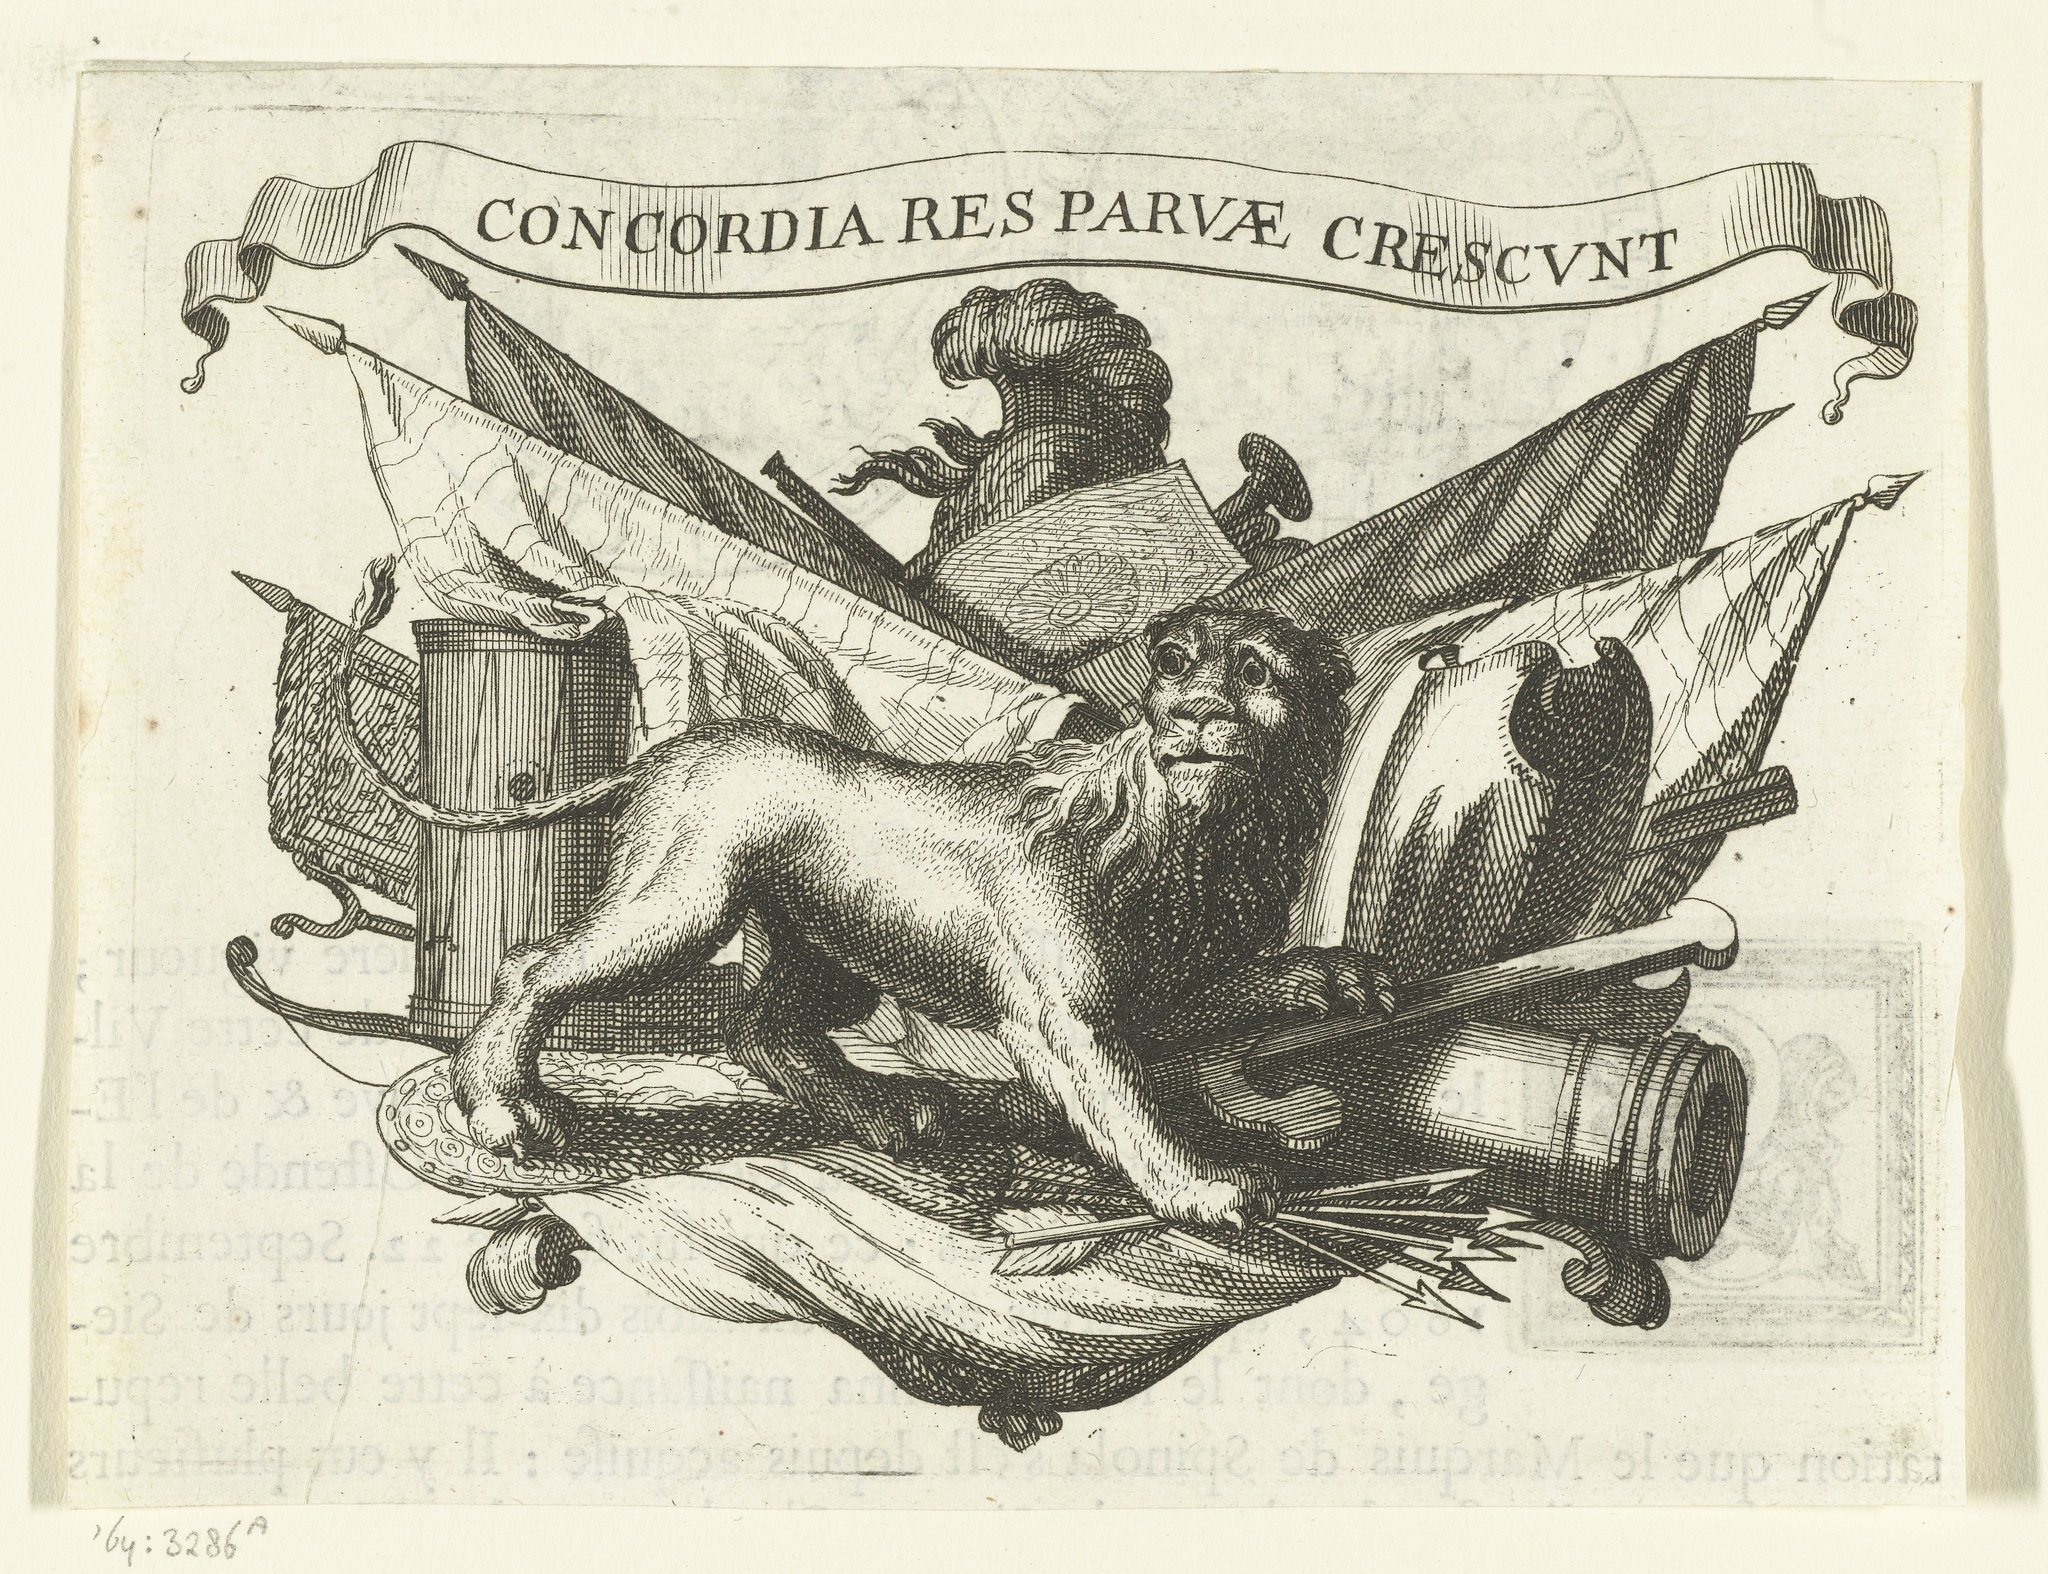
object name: print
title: Concordia res parvae crescvnt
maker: Anonymous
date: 1688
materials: paper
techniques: etching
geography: amsterdam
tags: trophy ~ battle, war, beasts of prey, predatory animals: lion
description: De leeuw staat met een van zijn voorpoten op een aantal pijlen. Uit serie vignetten met zeegoden en allegorieën, als illustratie gebruikt in het boek Histoire metallique de la république de Hollande van P. Bizot.